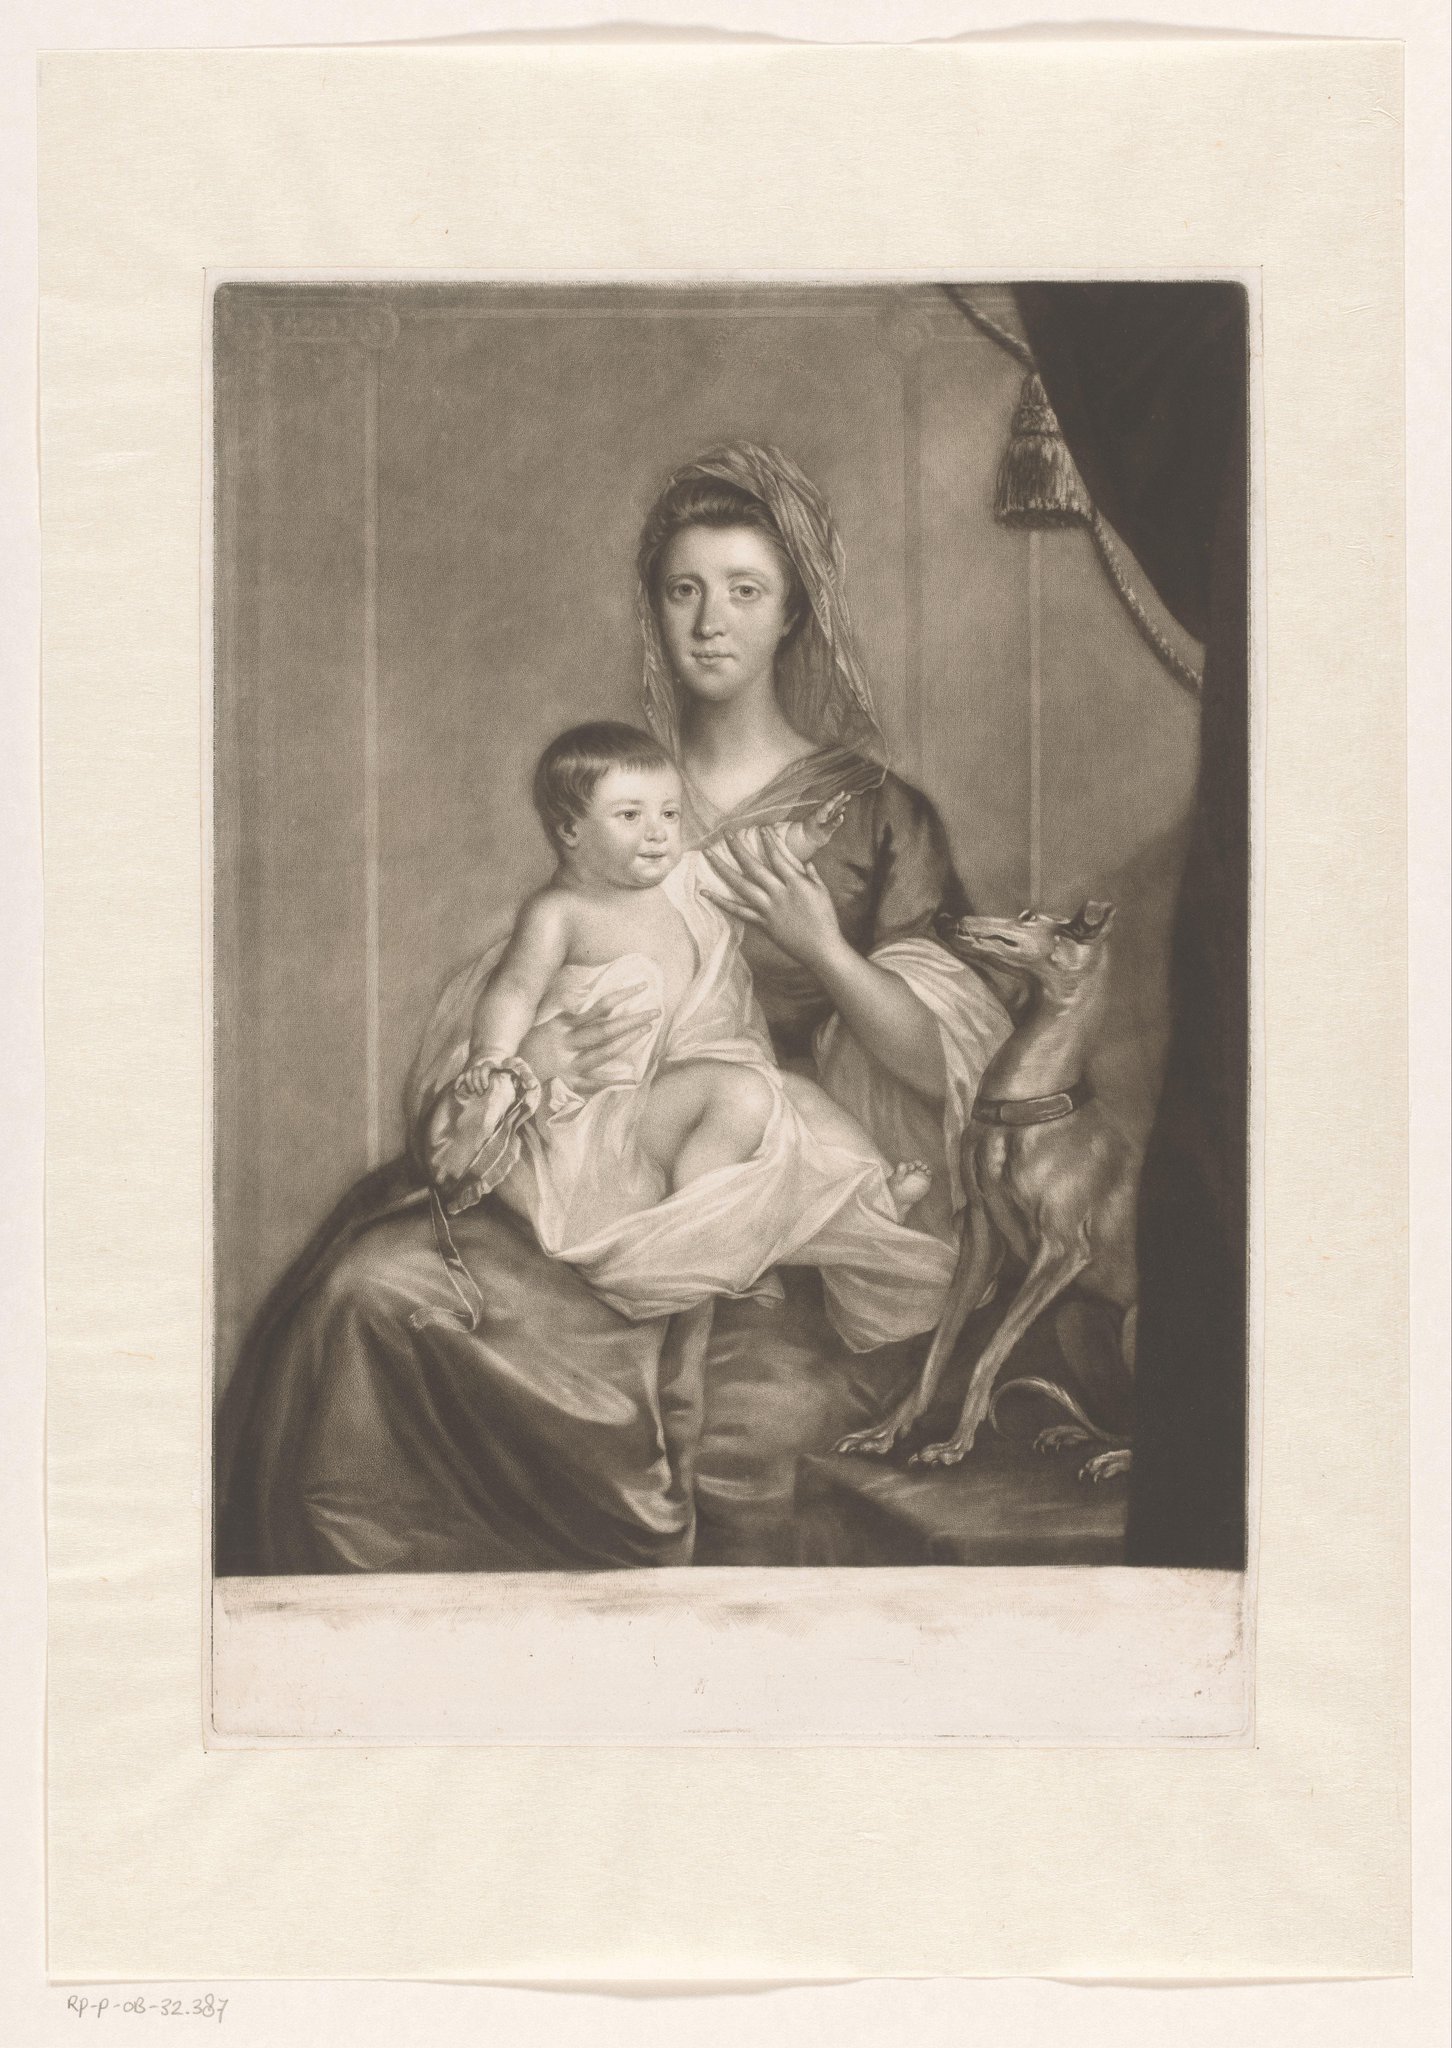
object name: print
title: Portret van Jane Cathcart en haar dochter Jane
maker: james mcardell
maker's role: print maker, publisher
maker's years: 1728-1765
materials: paper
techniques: mezzotint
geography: london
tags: historical person - woman - in a double portrait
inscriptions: collector's mark: Lugt 240